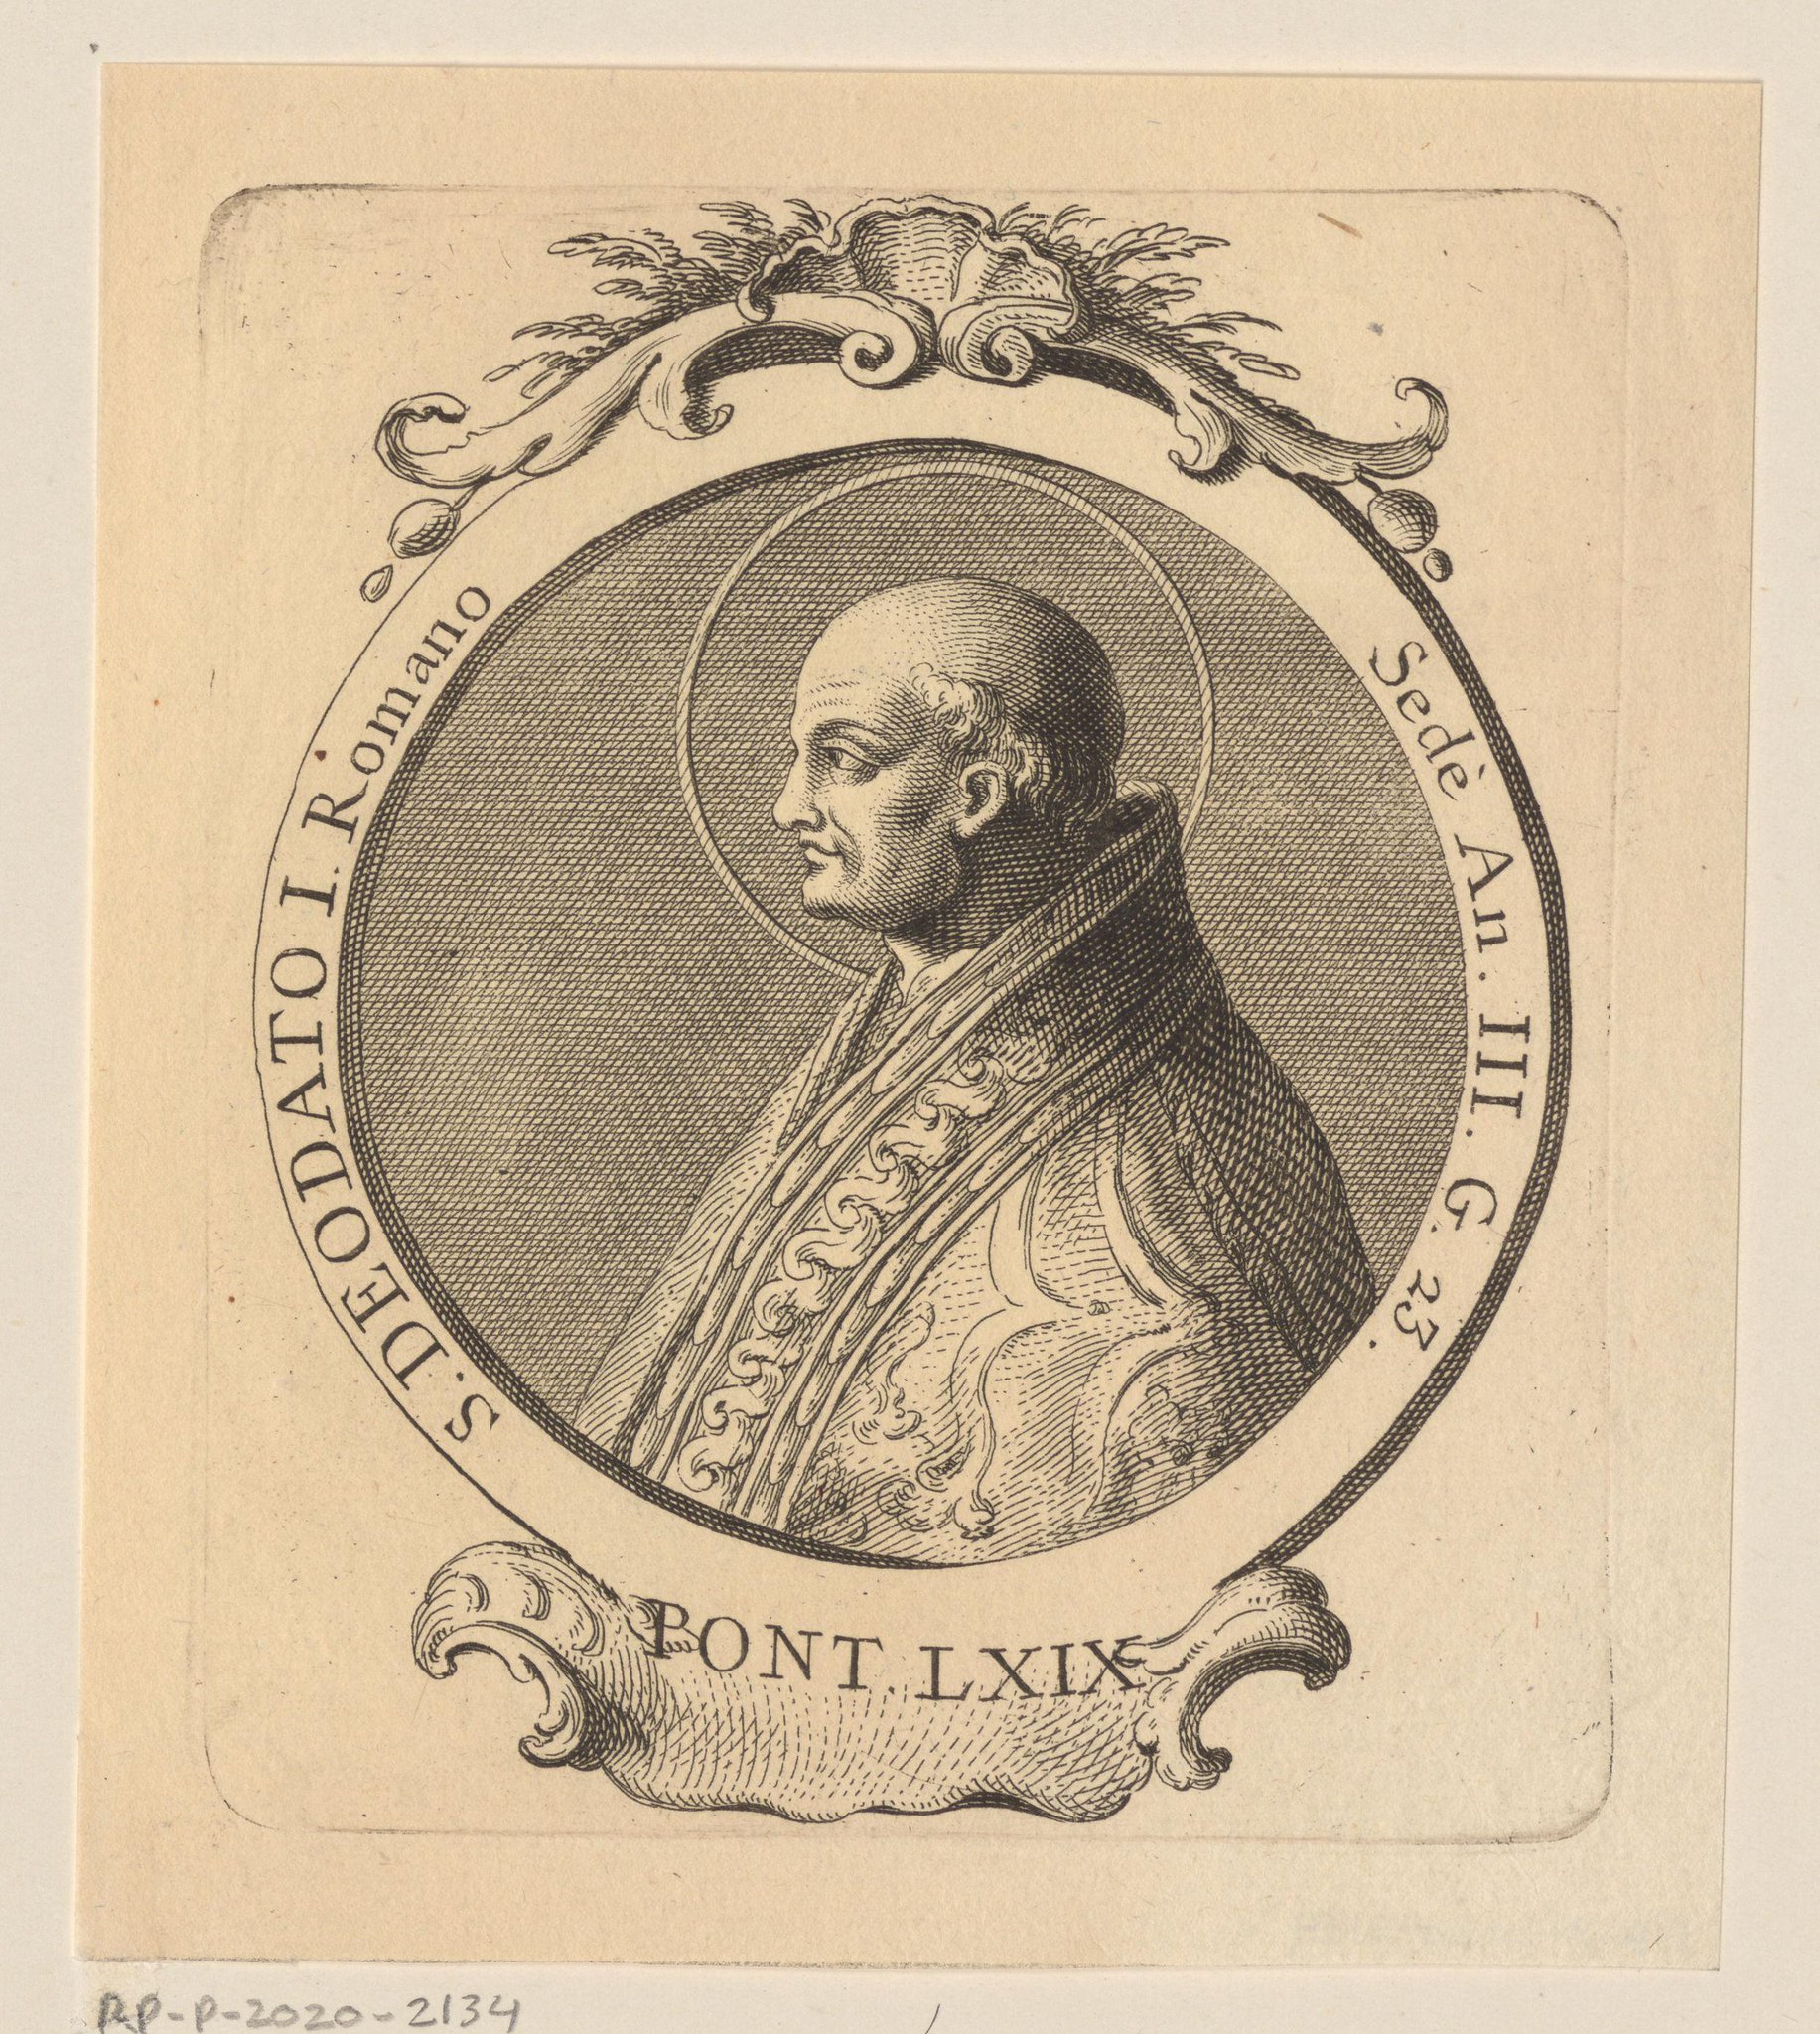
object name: print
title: Portret van paus Adeodatus I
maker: Anonymous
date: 1575-1674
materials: paper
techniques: etching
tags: rome, historical persons, pope